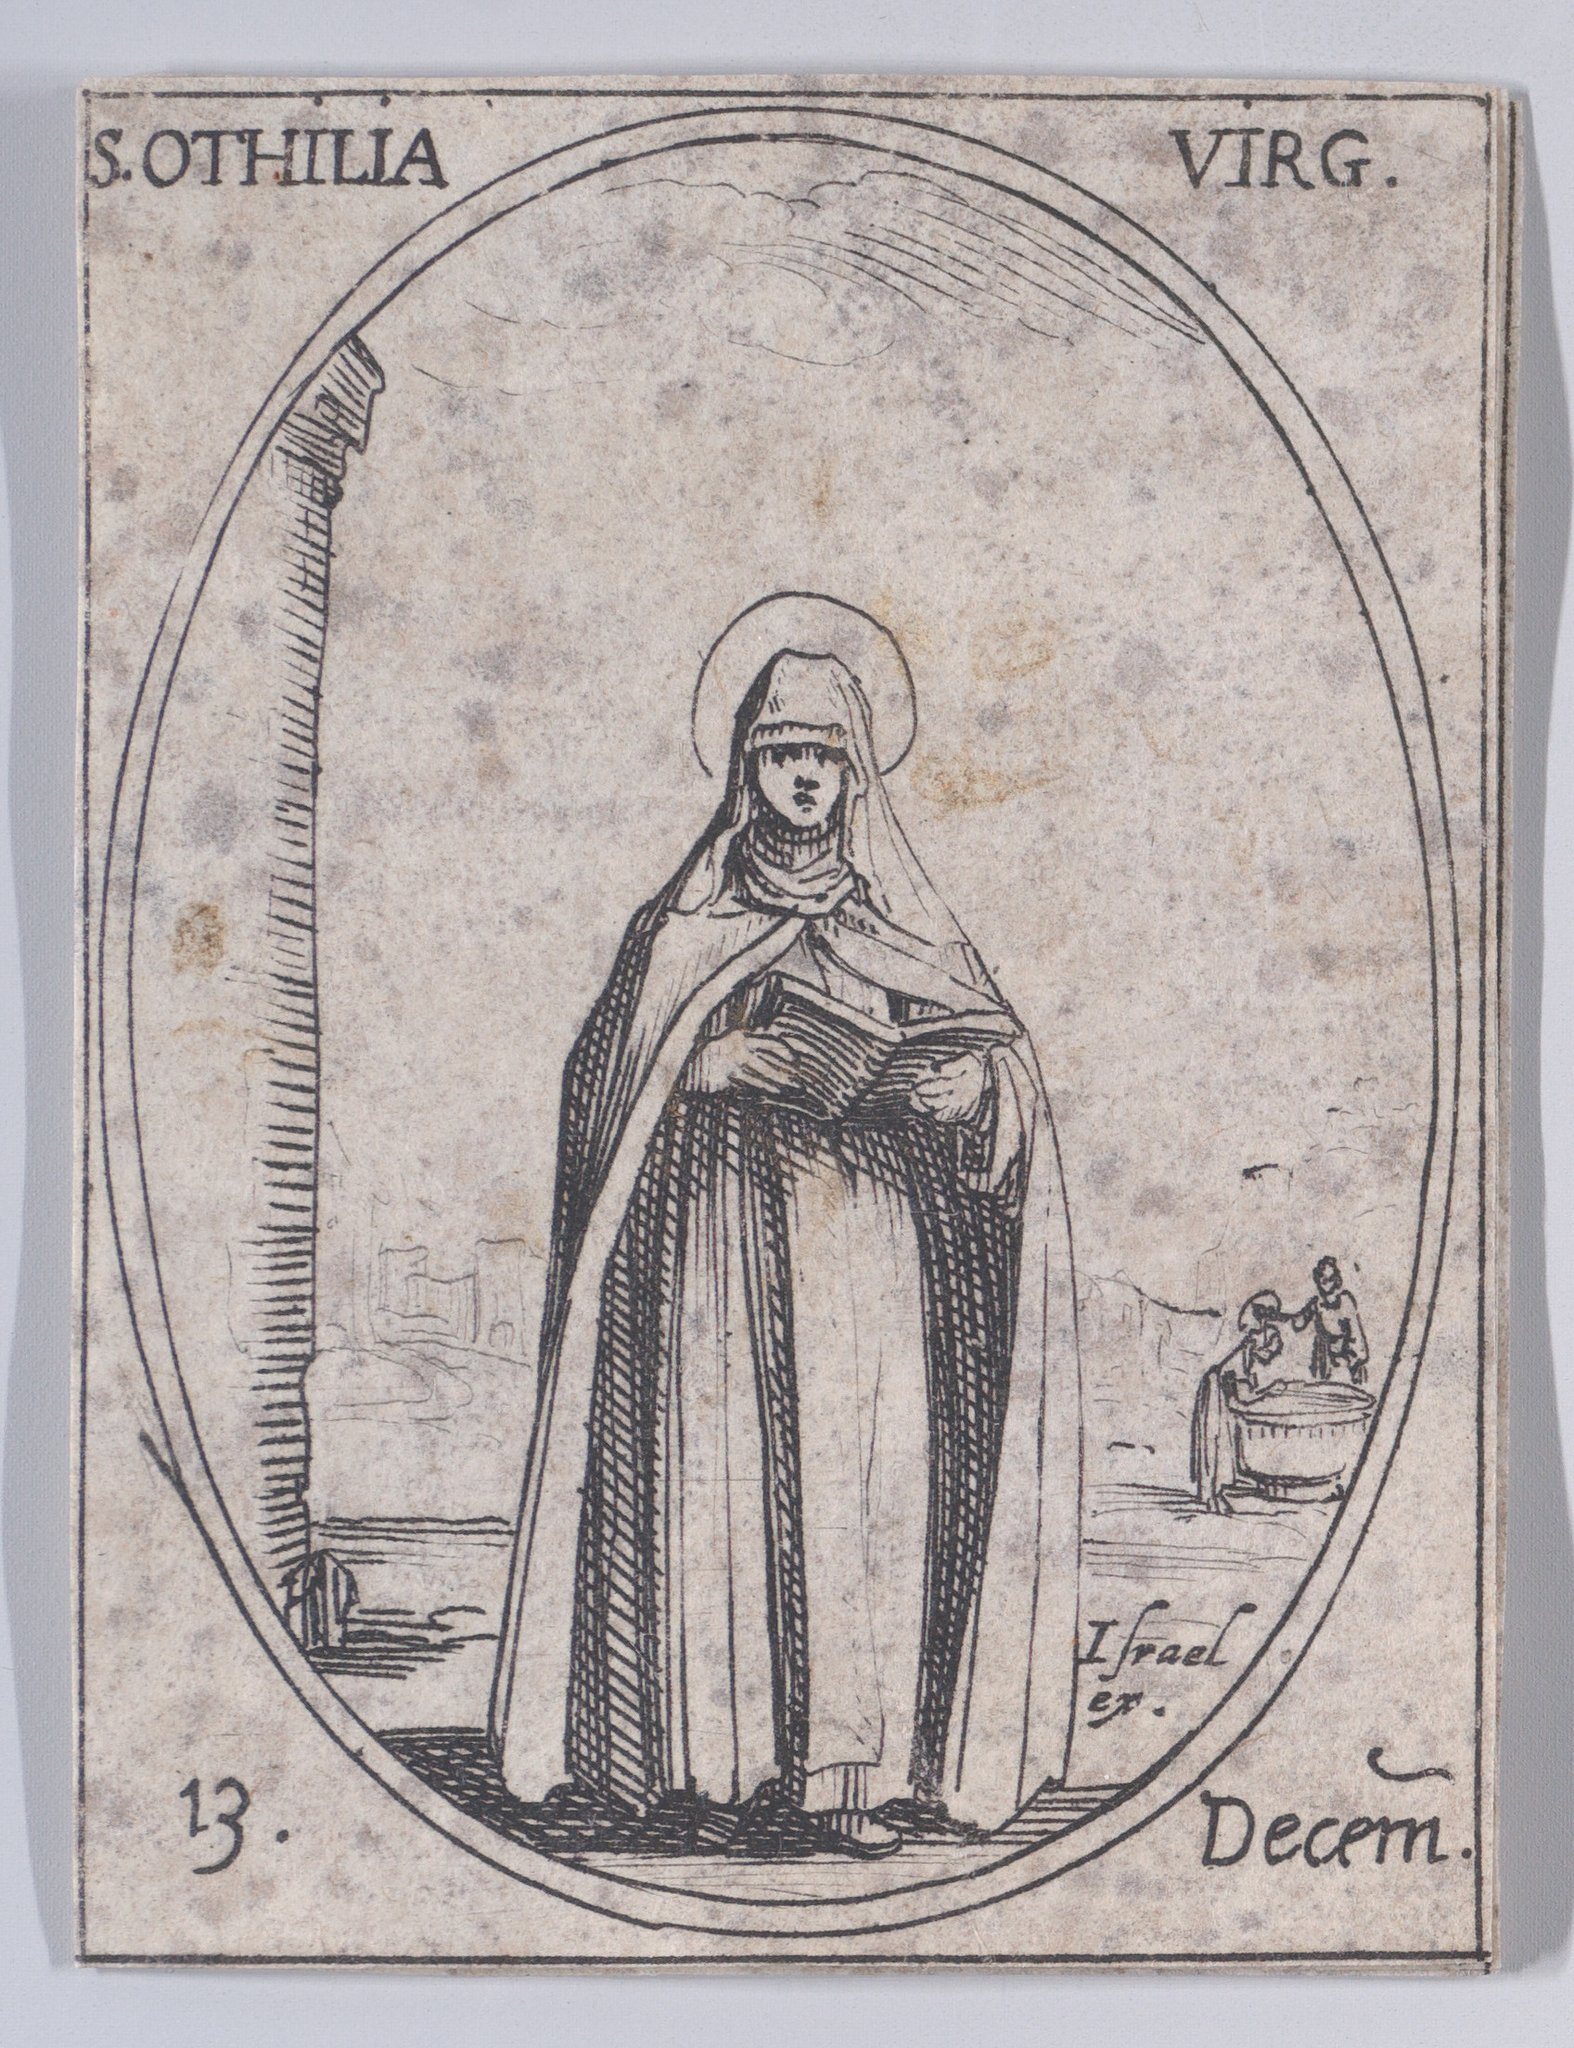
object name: print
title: Ste. Othilie, vierge (St. Odilia, Virgin), December 13th, from "Les Images De Tous Les Saincts et Saintes de L'Année" (Images of All of the Saints and Religious Events of the Year)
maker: jacques callot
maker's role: artist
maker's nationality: french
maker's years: 1592-1635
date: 1636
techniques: etching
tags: women,saints